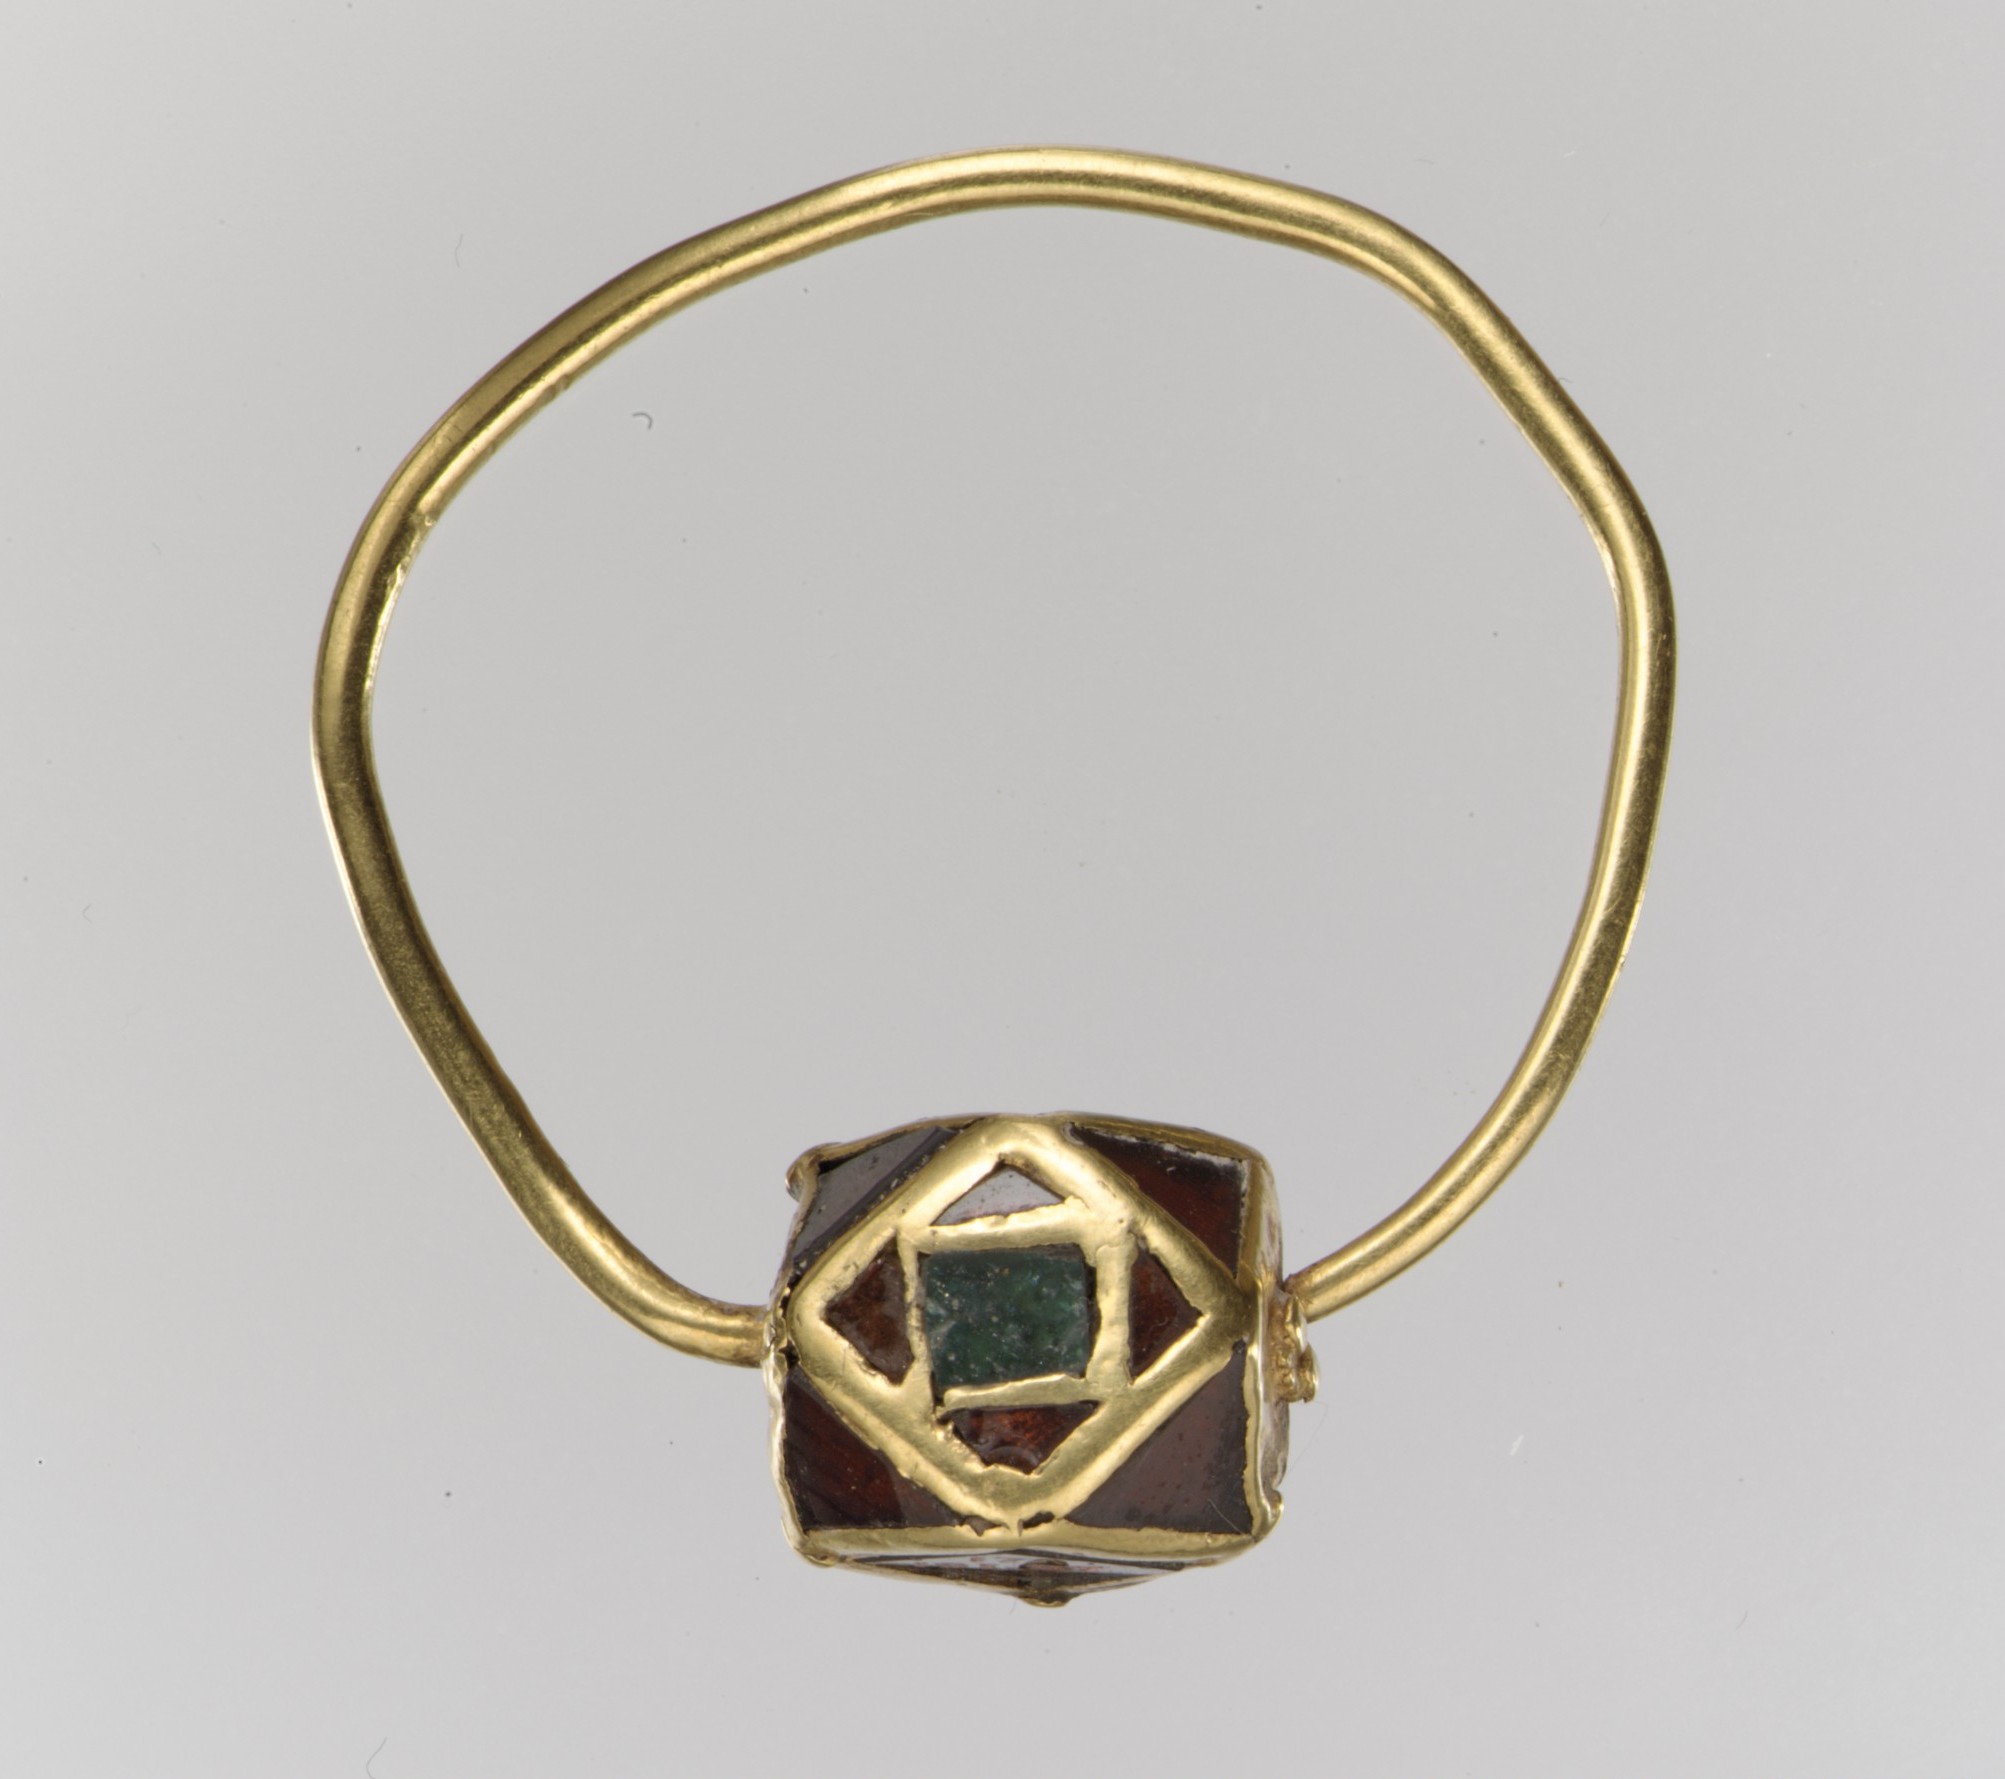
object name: earring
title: One of a Pair of Gold Cloisonné Earrings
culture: frankish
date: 500-550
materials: foil, garnet, gold, stone